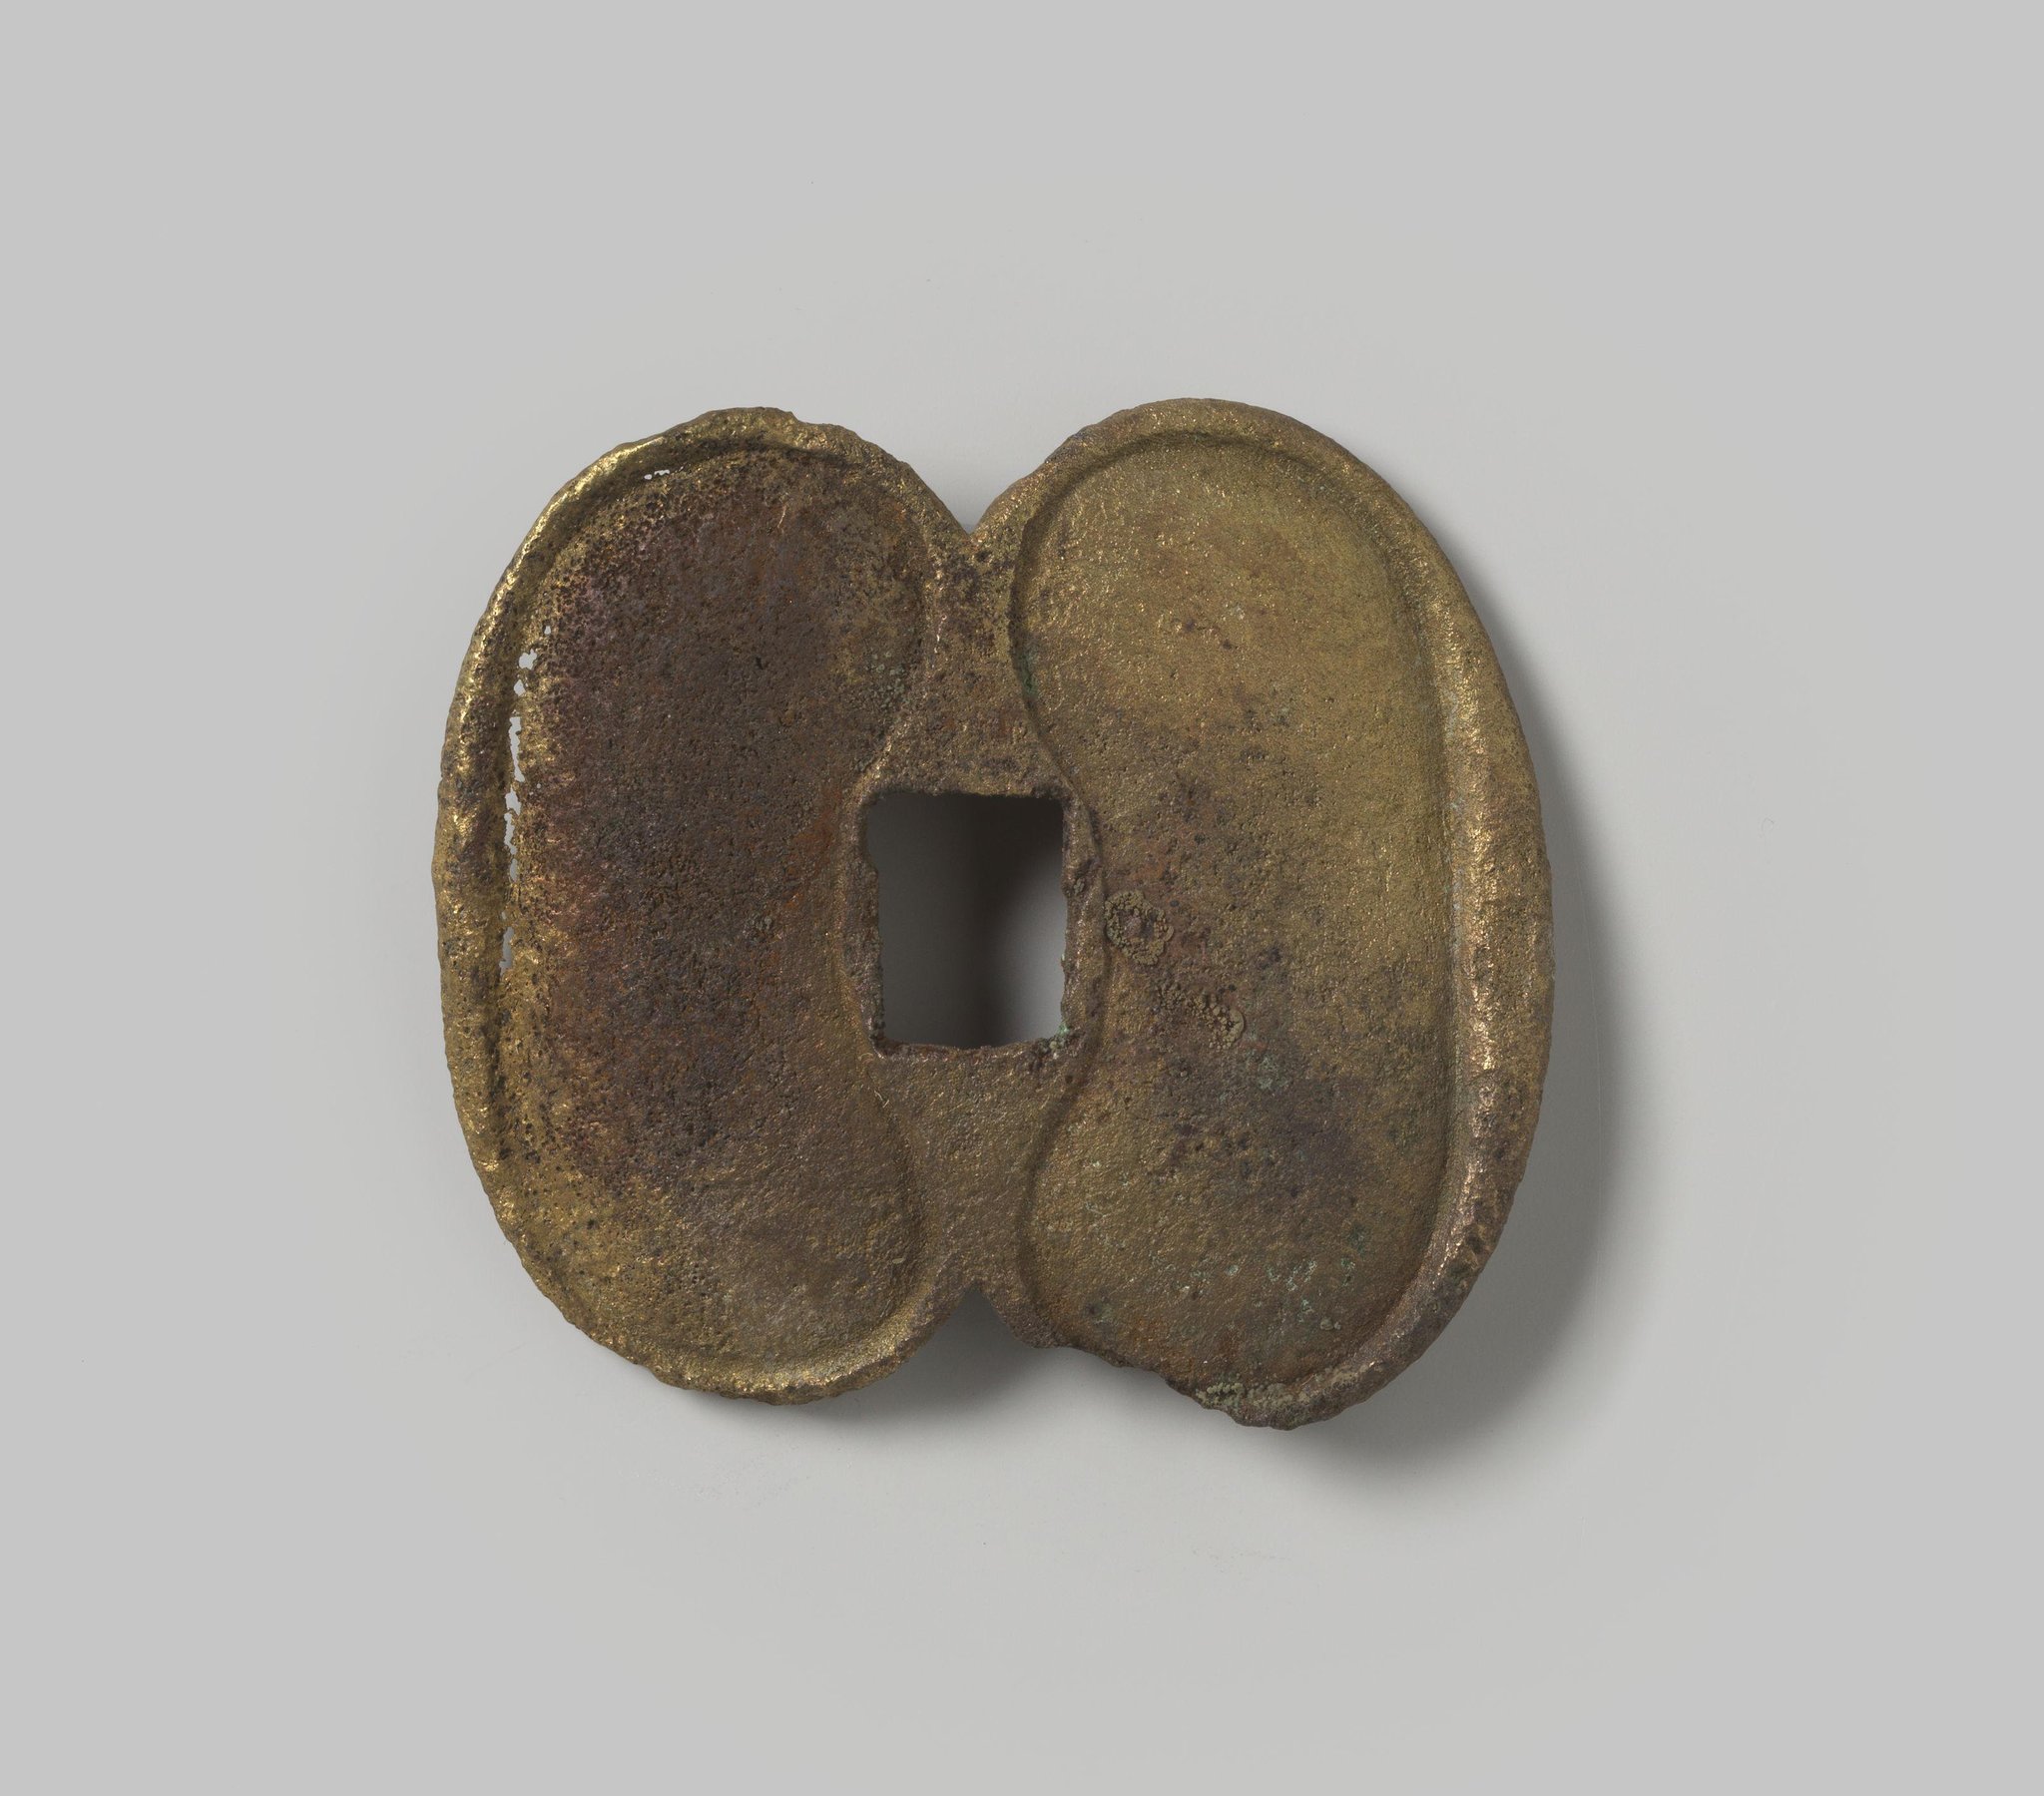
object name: sword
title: Pareerplaat van een degen uit het wrak van de Oostindiëvaarder Hollandia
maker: Anonymous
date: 1700-1743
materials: brass